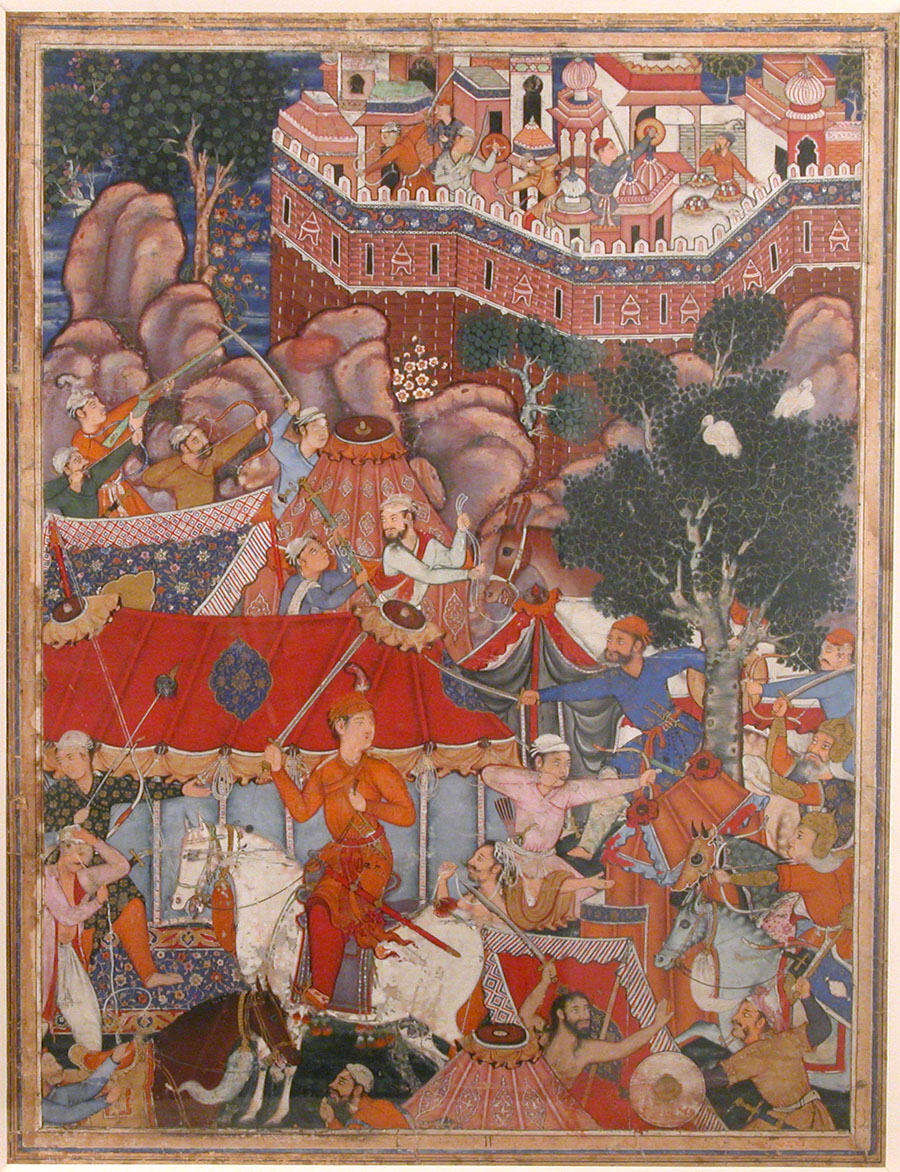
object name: folio from an illustrated manuscript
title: "Assad Ibn Kariba Launches a Night Attack on the Camp of Malik Iraj", Folio from a Hamzanama (The Adventures of Hamza)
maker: basavana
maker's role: artist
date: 1564-1569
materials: textile, gold, ink, paper, watercolor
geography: kashmir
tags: battles,soldiers,men,horses